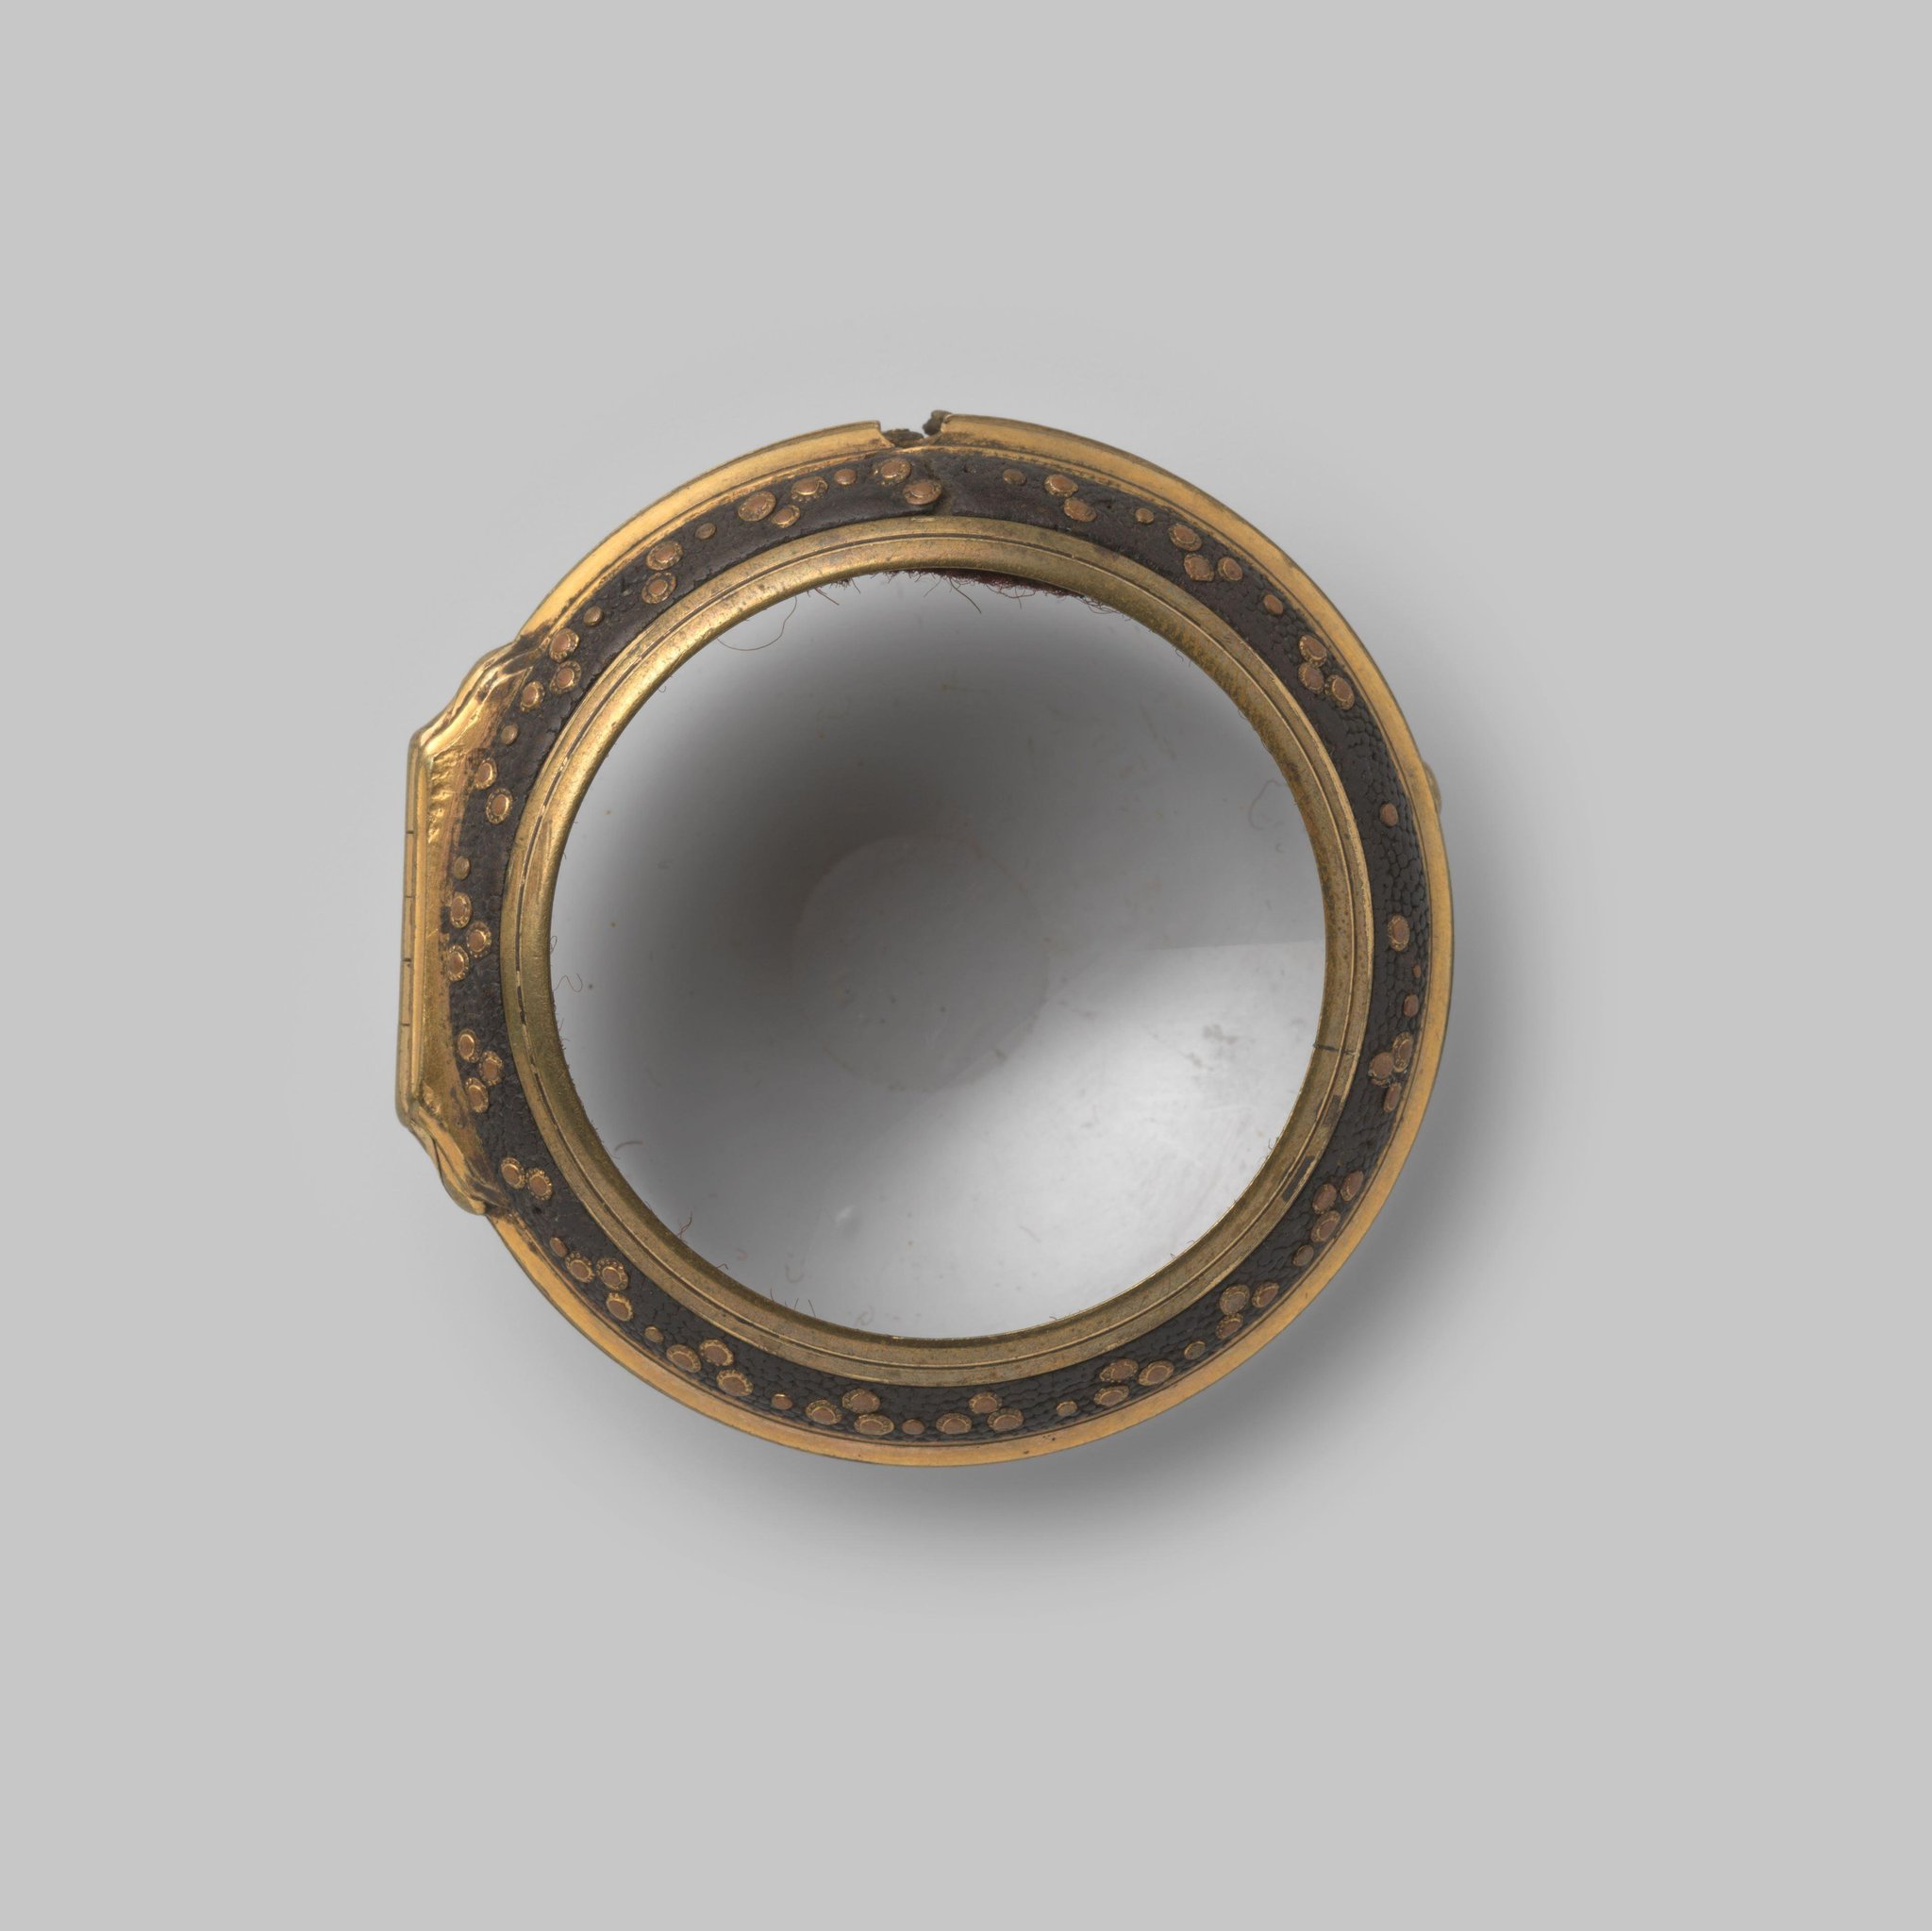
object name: pocket watch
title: Tweede kast van horloge met de aanbidding der herders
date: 1762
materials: copper, skin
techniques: repoussé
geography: amsterdam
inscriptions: duty mark: ‘V’, town mark, date letter: ‘C’, maker's mark, signature: ‘J.M. Juntes // Amsterdam’, inscription: ‘GLOIRE SOIT A DIEU/AUX LIEUX/TRES HAUTS & EN TERRE PAIX/ENVERS LES HOMMES/BONNE VOLONTE’, alloy mark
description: Etui van haaienvel met verguld koperen spijkerkoppen.